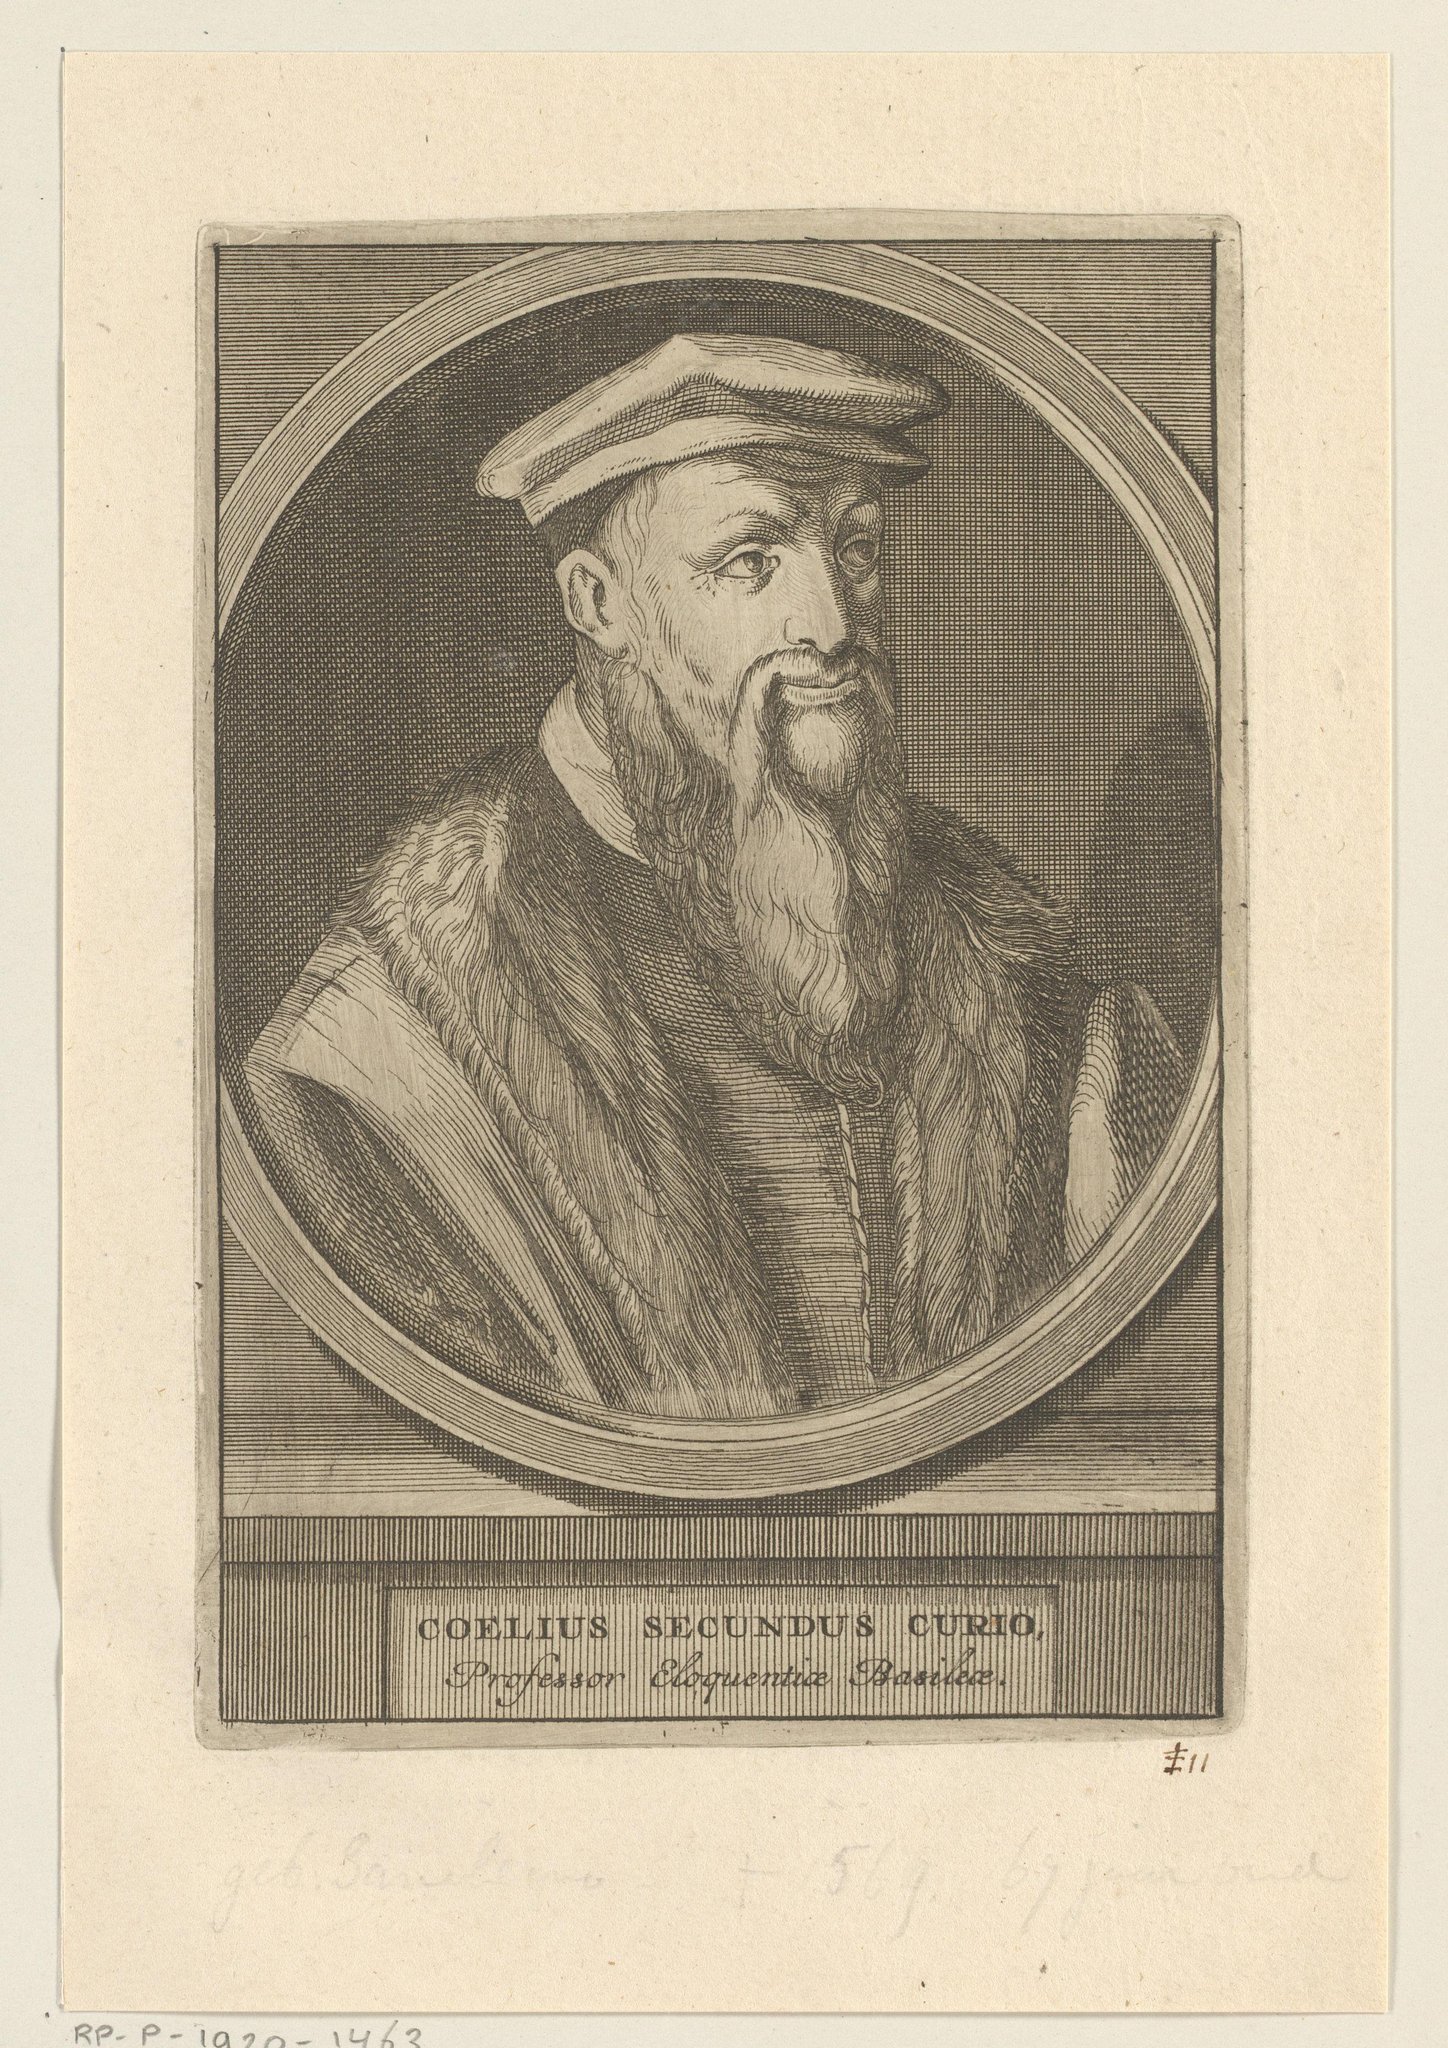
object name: print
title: Imagines XLI virorum celebriorum in politicis, historicis &c.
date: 1610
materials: paper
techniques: engraving, intaglio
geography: leiden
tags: scholar, philosopher, historical persons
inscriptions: inscription: ‘*11’, collector's mark: Lugt 2228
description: Eerste staat van de prent verschenen in: Effigies praestant aliquot virorum qui veram in primis religion nostro seculo propagarunt. Den Haag: Hendrick Hondius, [ca. 1610].